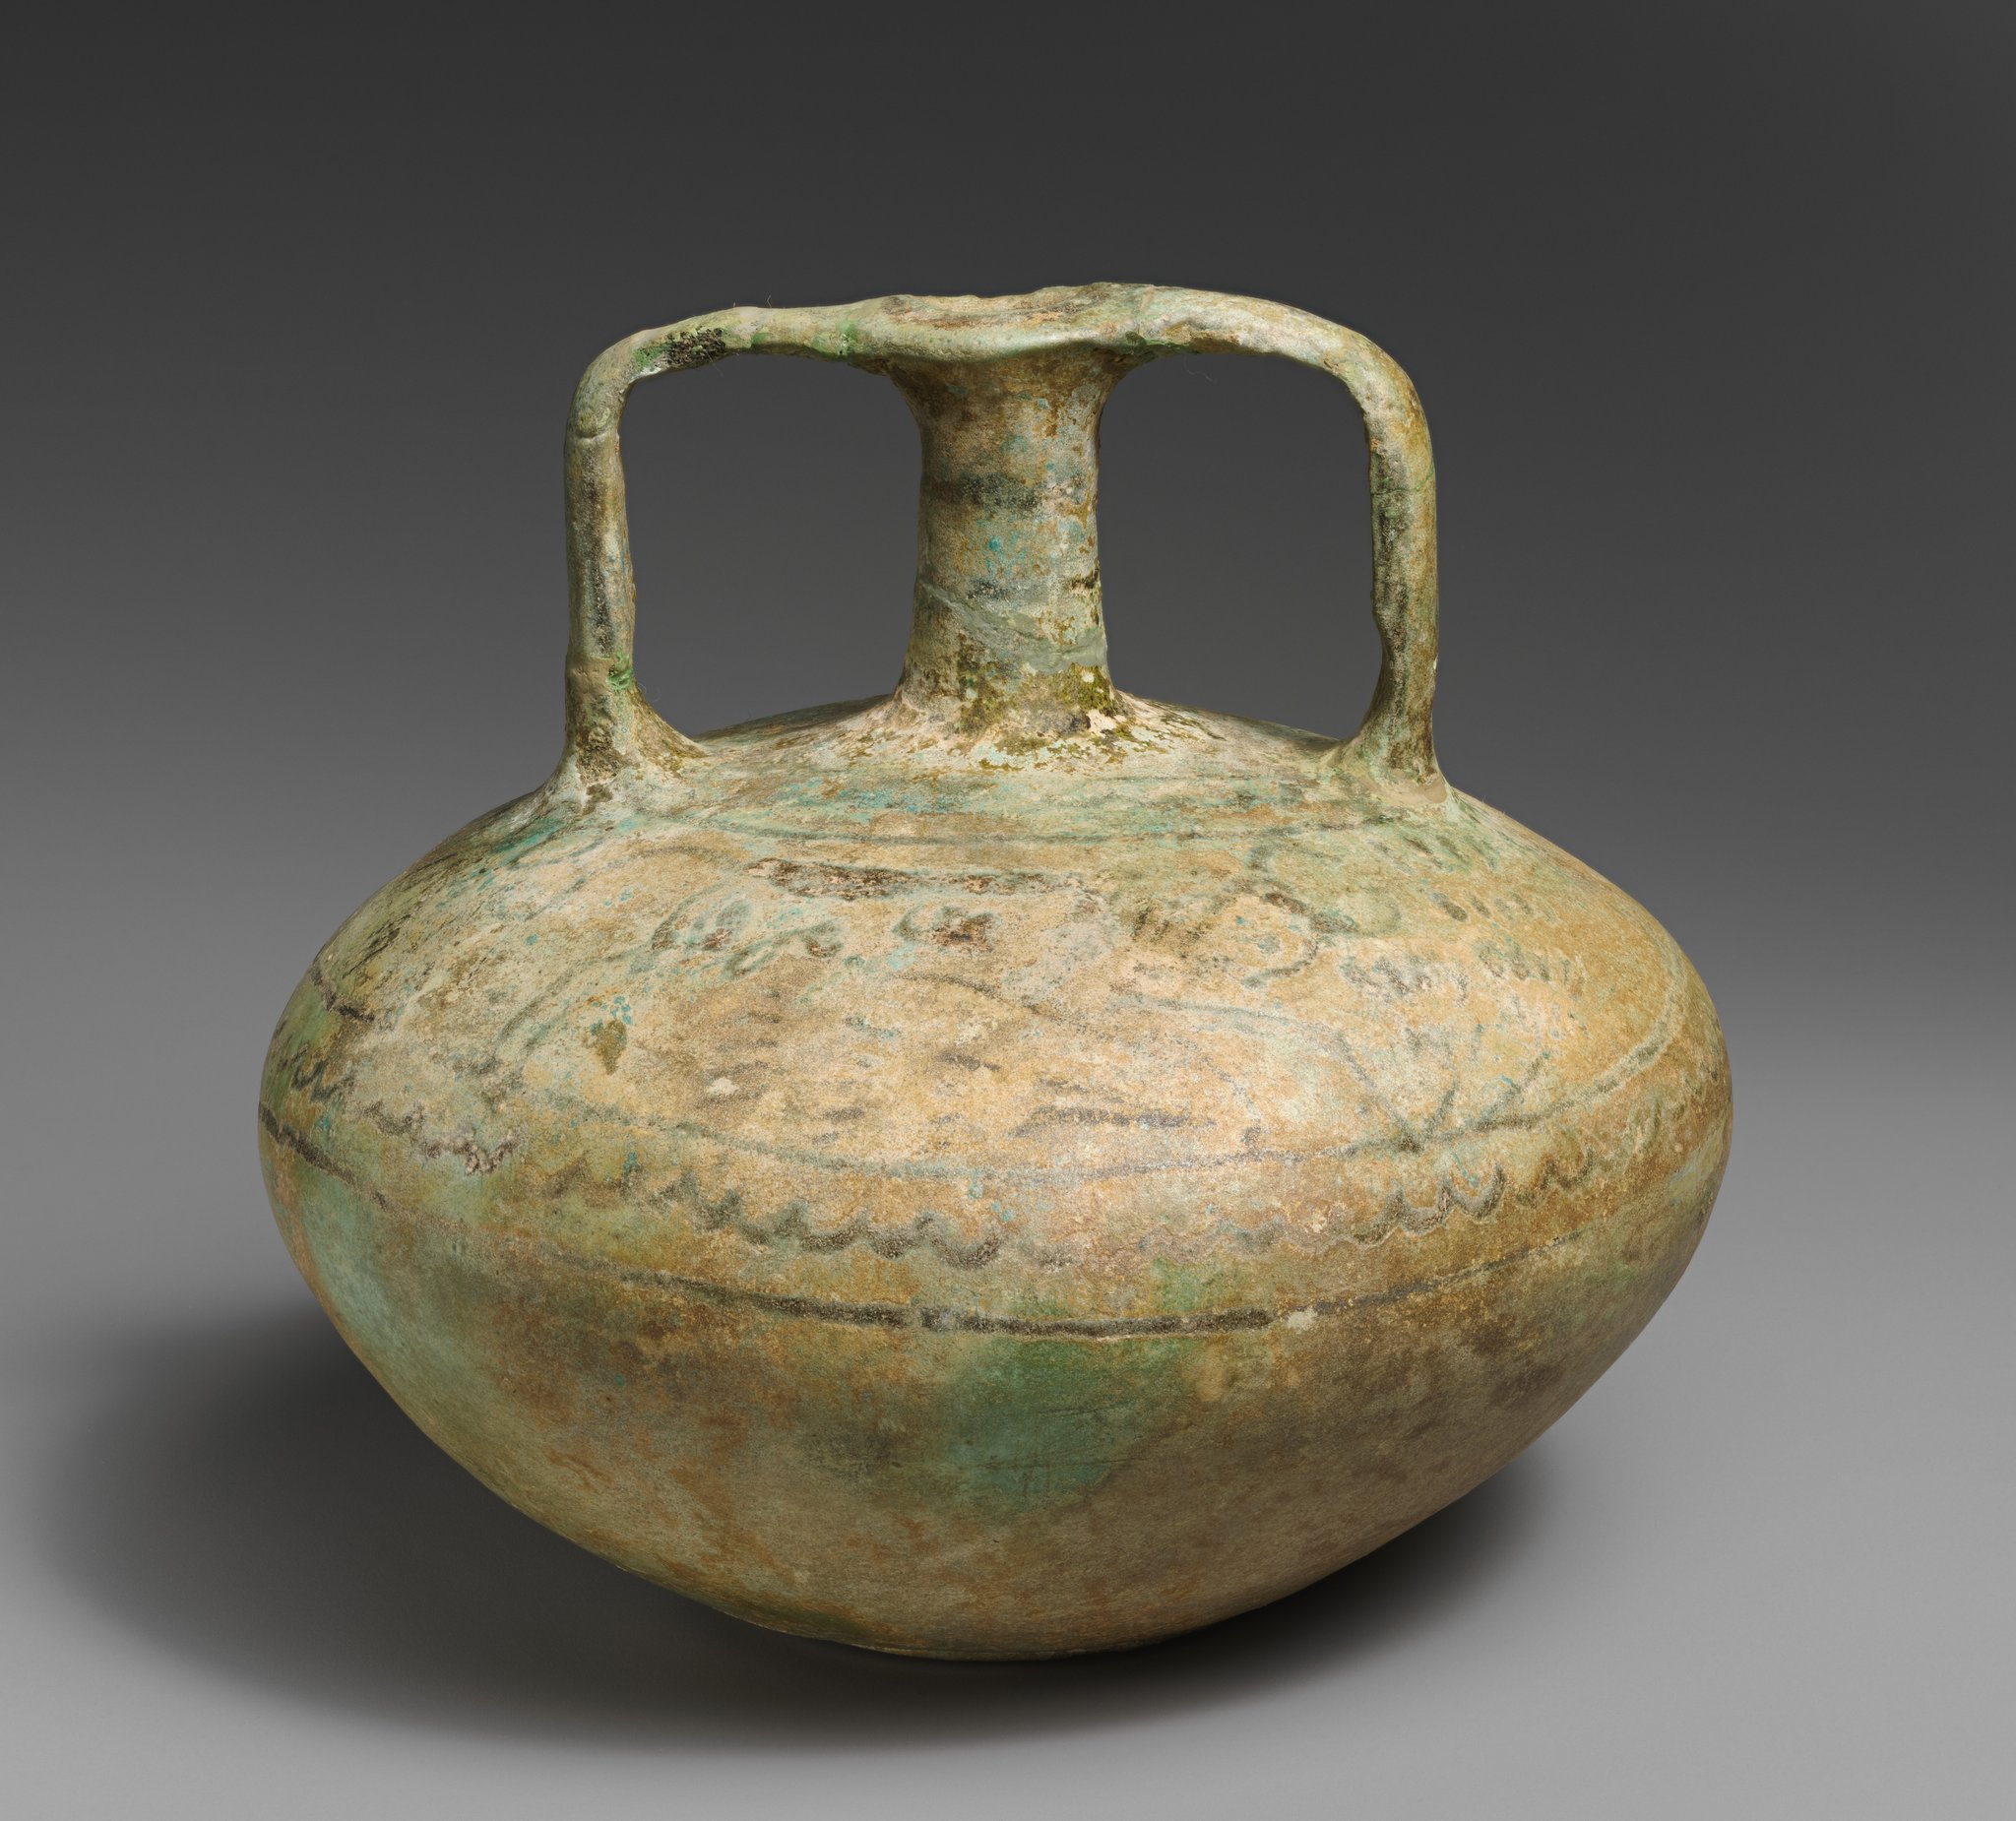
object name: stirrup jar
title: Faience stirrup jar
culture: cypriot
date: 1300-1101 BCE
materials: faience